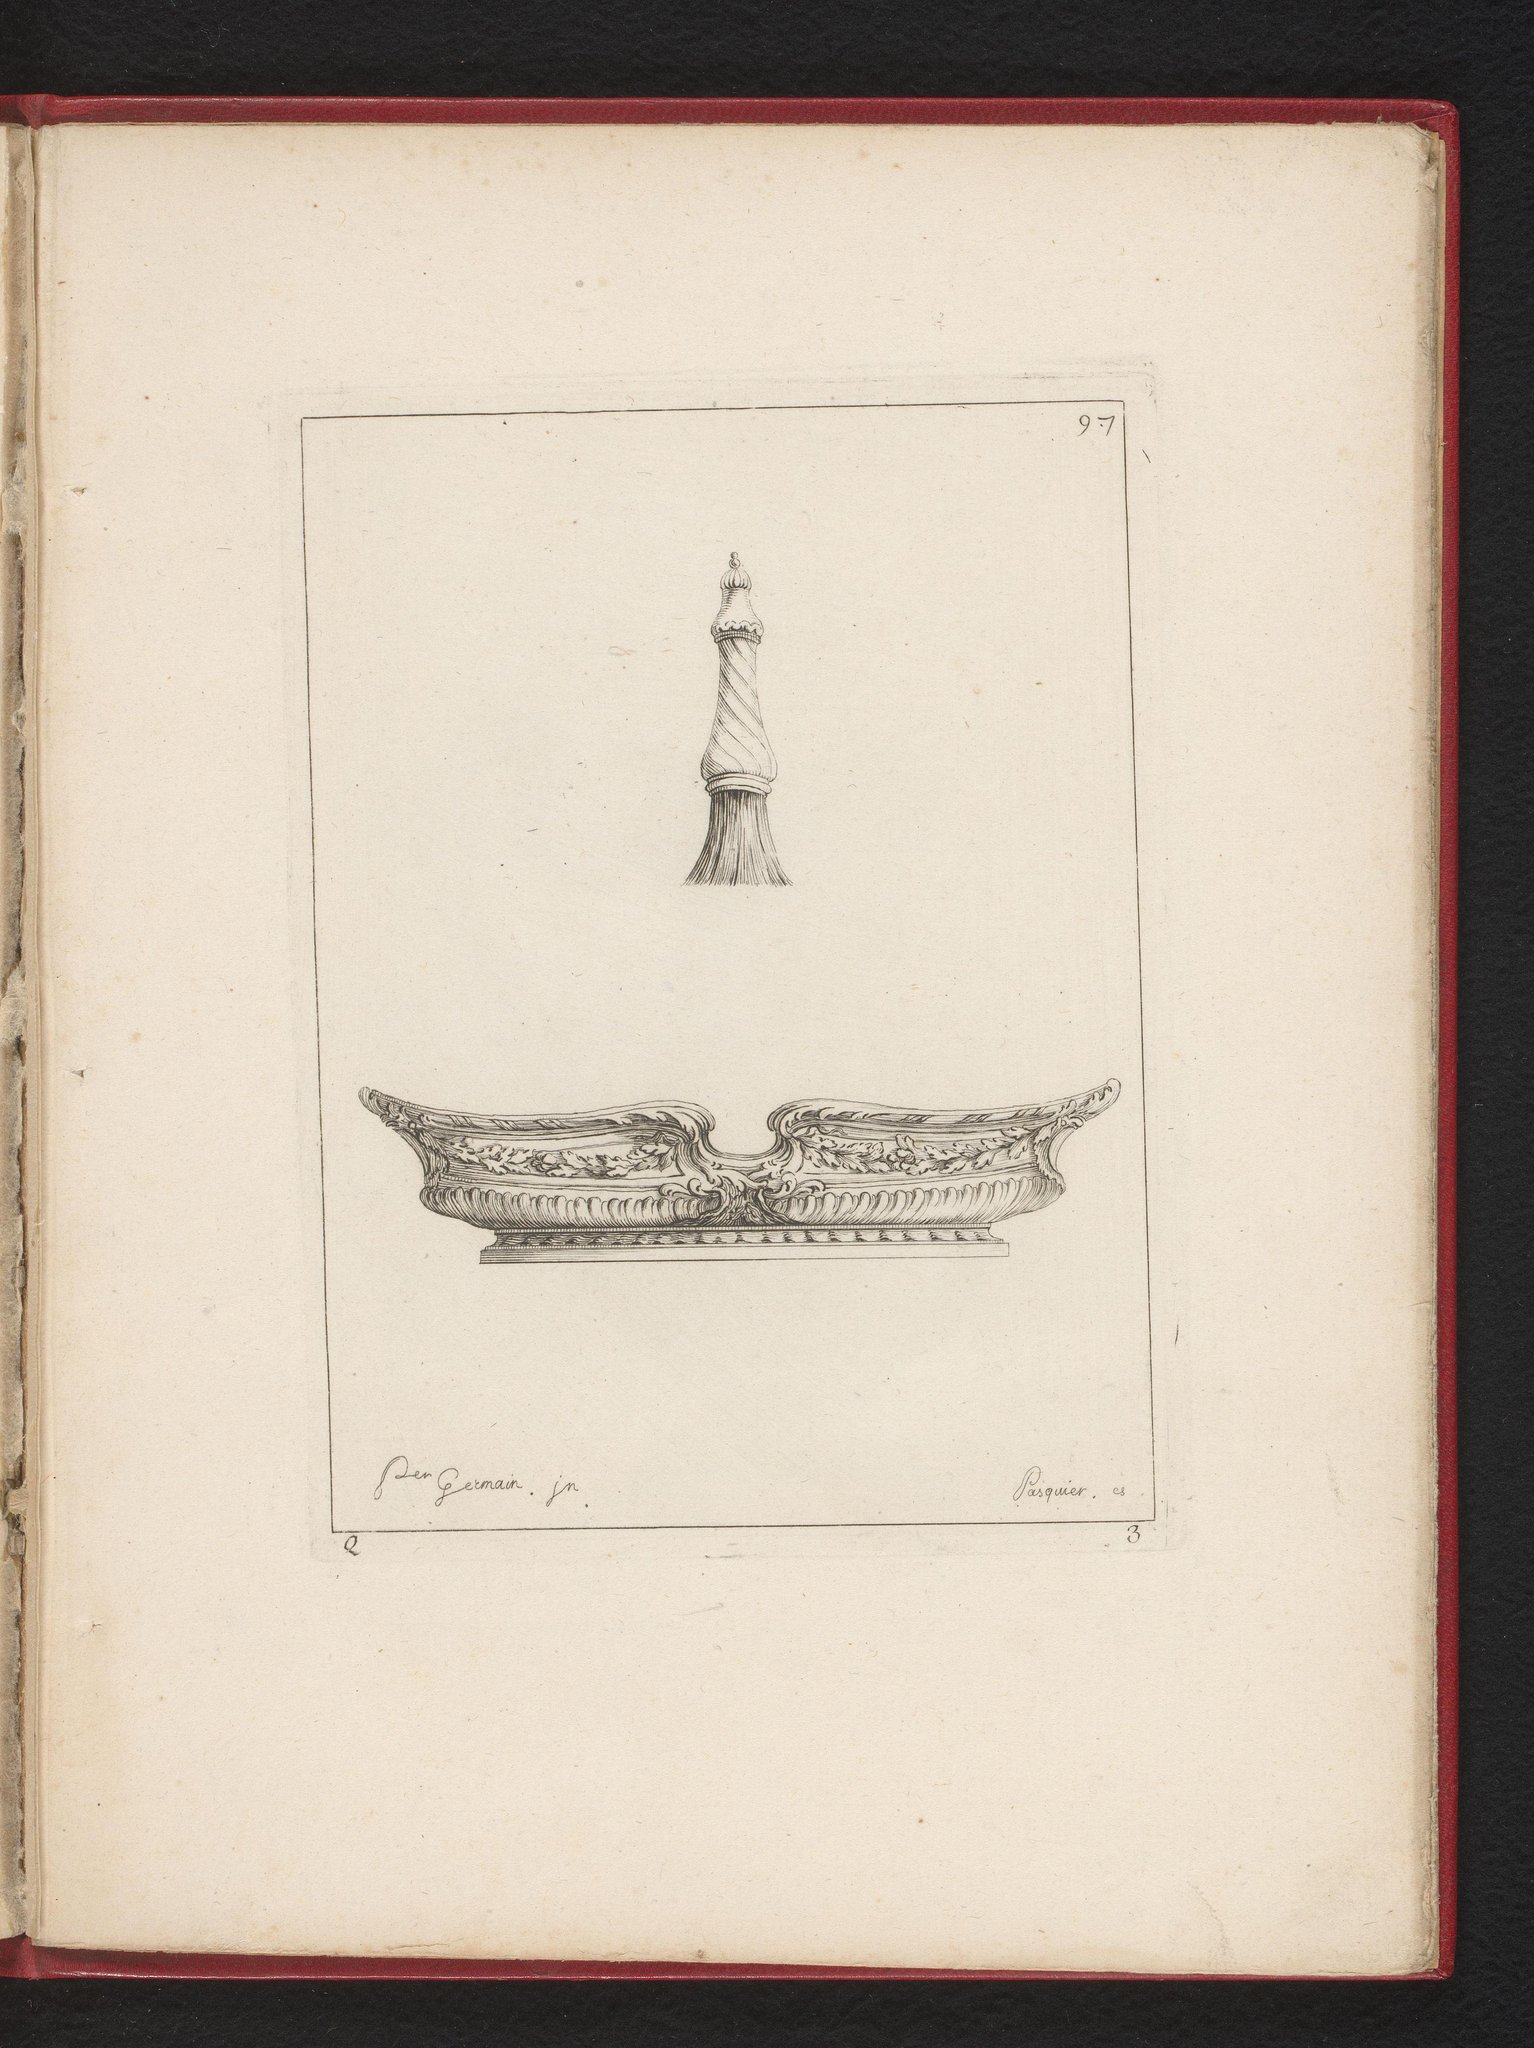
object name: album leaf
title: Ontwerp voor een kamborstel en kom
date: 1748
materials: paper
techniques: etching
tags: comb, brush and other tools (care of the hair), bowl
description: Een kamborstel werd gebruikt om de haren mee uit kammen te halen. Een aantal van de objecten in deze reeks heeft een eigen ondertitel, die verwijst naar genummerde 'cahiers' (afleveringen) waarin de prenten werden uitgegeven. Het is onduidelijk welke objecten recies bij welke aflevering horen. Daarom is die ondertitel enkel verwerkt bij de prent waarop die voorkomt.